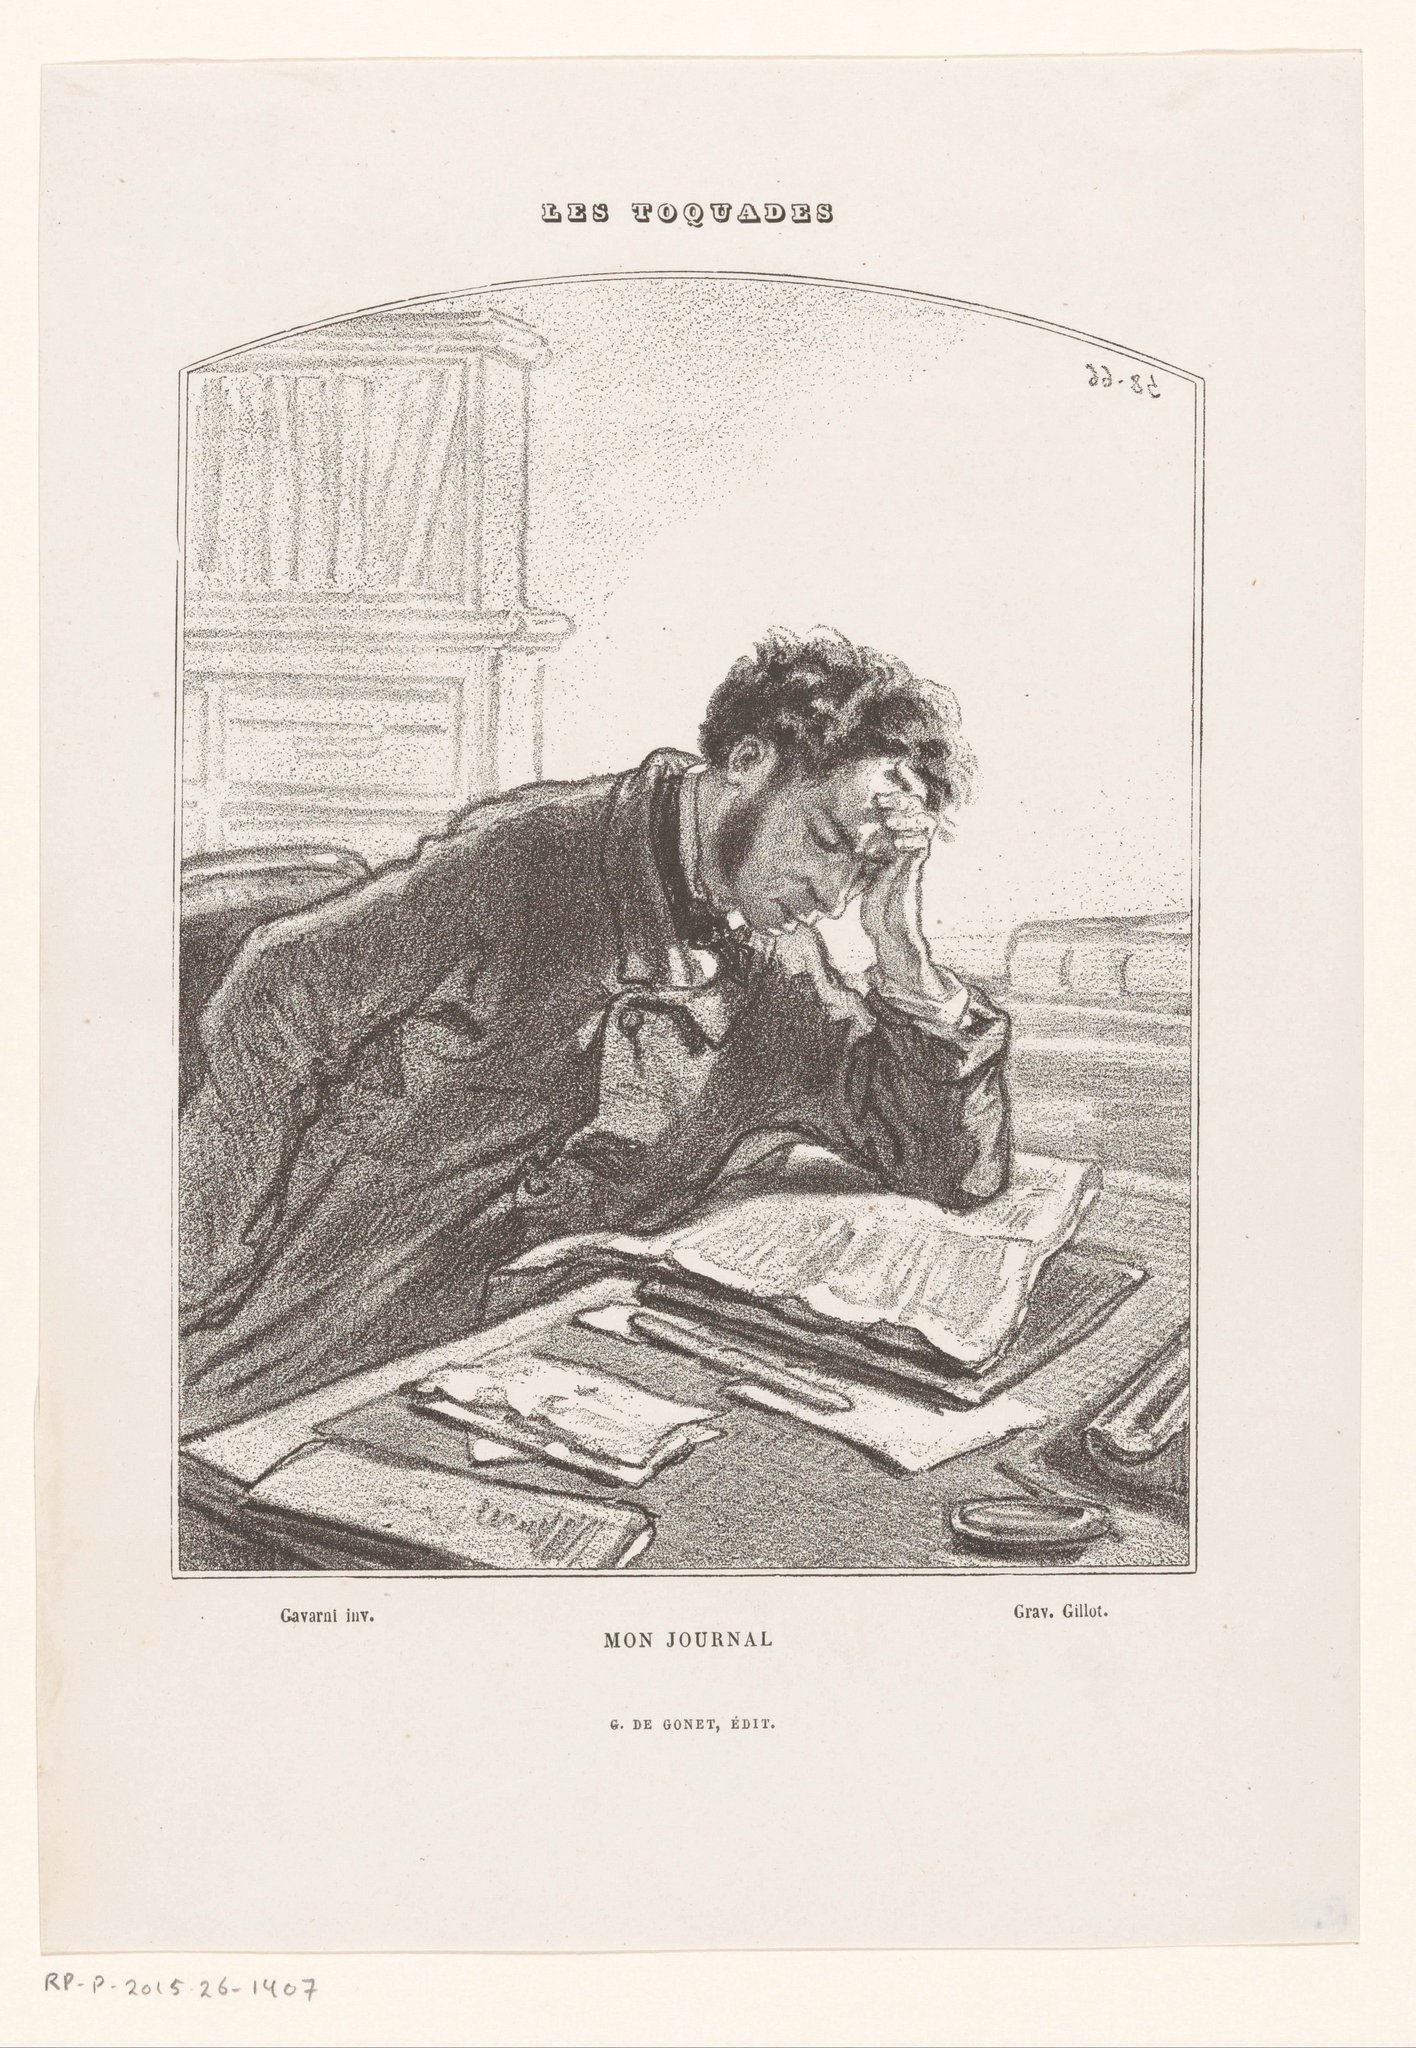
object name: book illustration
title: Man achter een bureau, lezend in een krant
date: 1858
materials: paper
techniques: gillotage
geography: paris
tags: print, e.g.: engraving, etching, lithograph, art dealer, art collecting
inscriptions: collector's mark: Lugt 4779, collector's mark: Lugt 2228, collector's mark: Lugt 4780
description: Prent gebruikt in: Les Toquades illustrées par Gavarni. Étude de moeurs par Ch. de Bussy. Parijs: P. Martinon en G. de Gonet, [1858], na p. 8. Nummer drie uit een serie van twintig prenten.